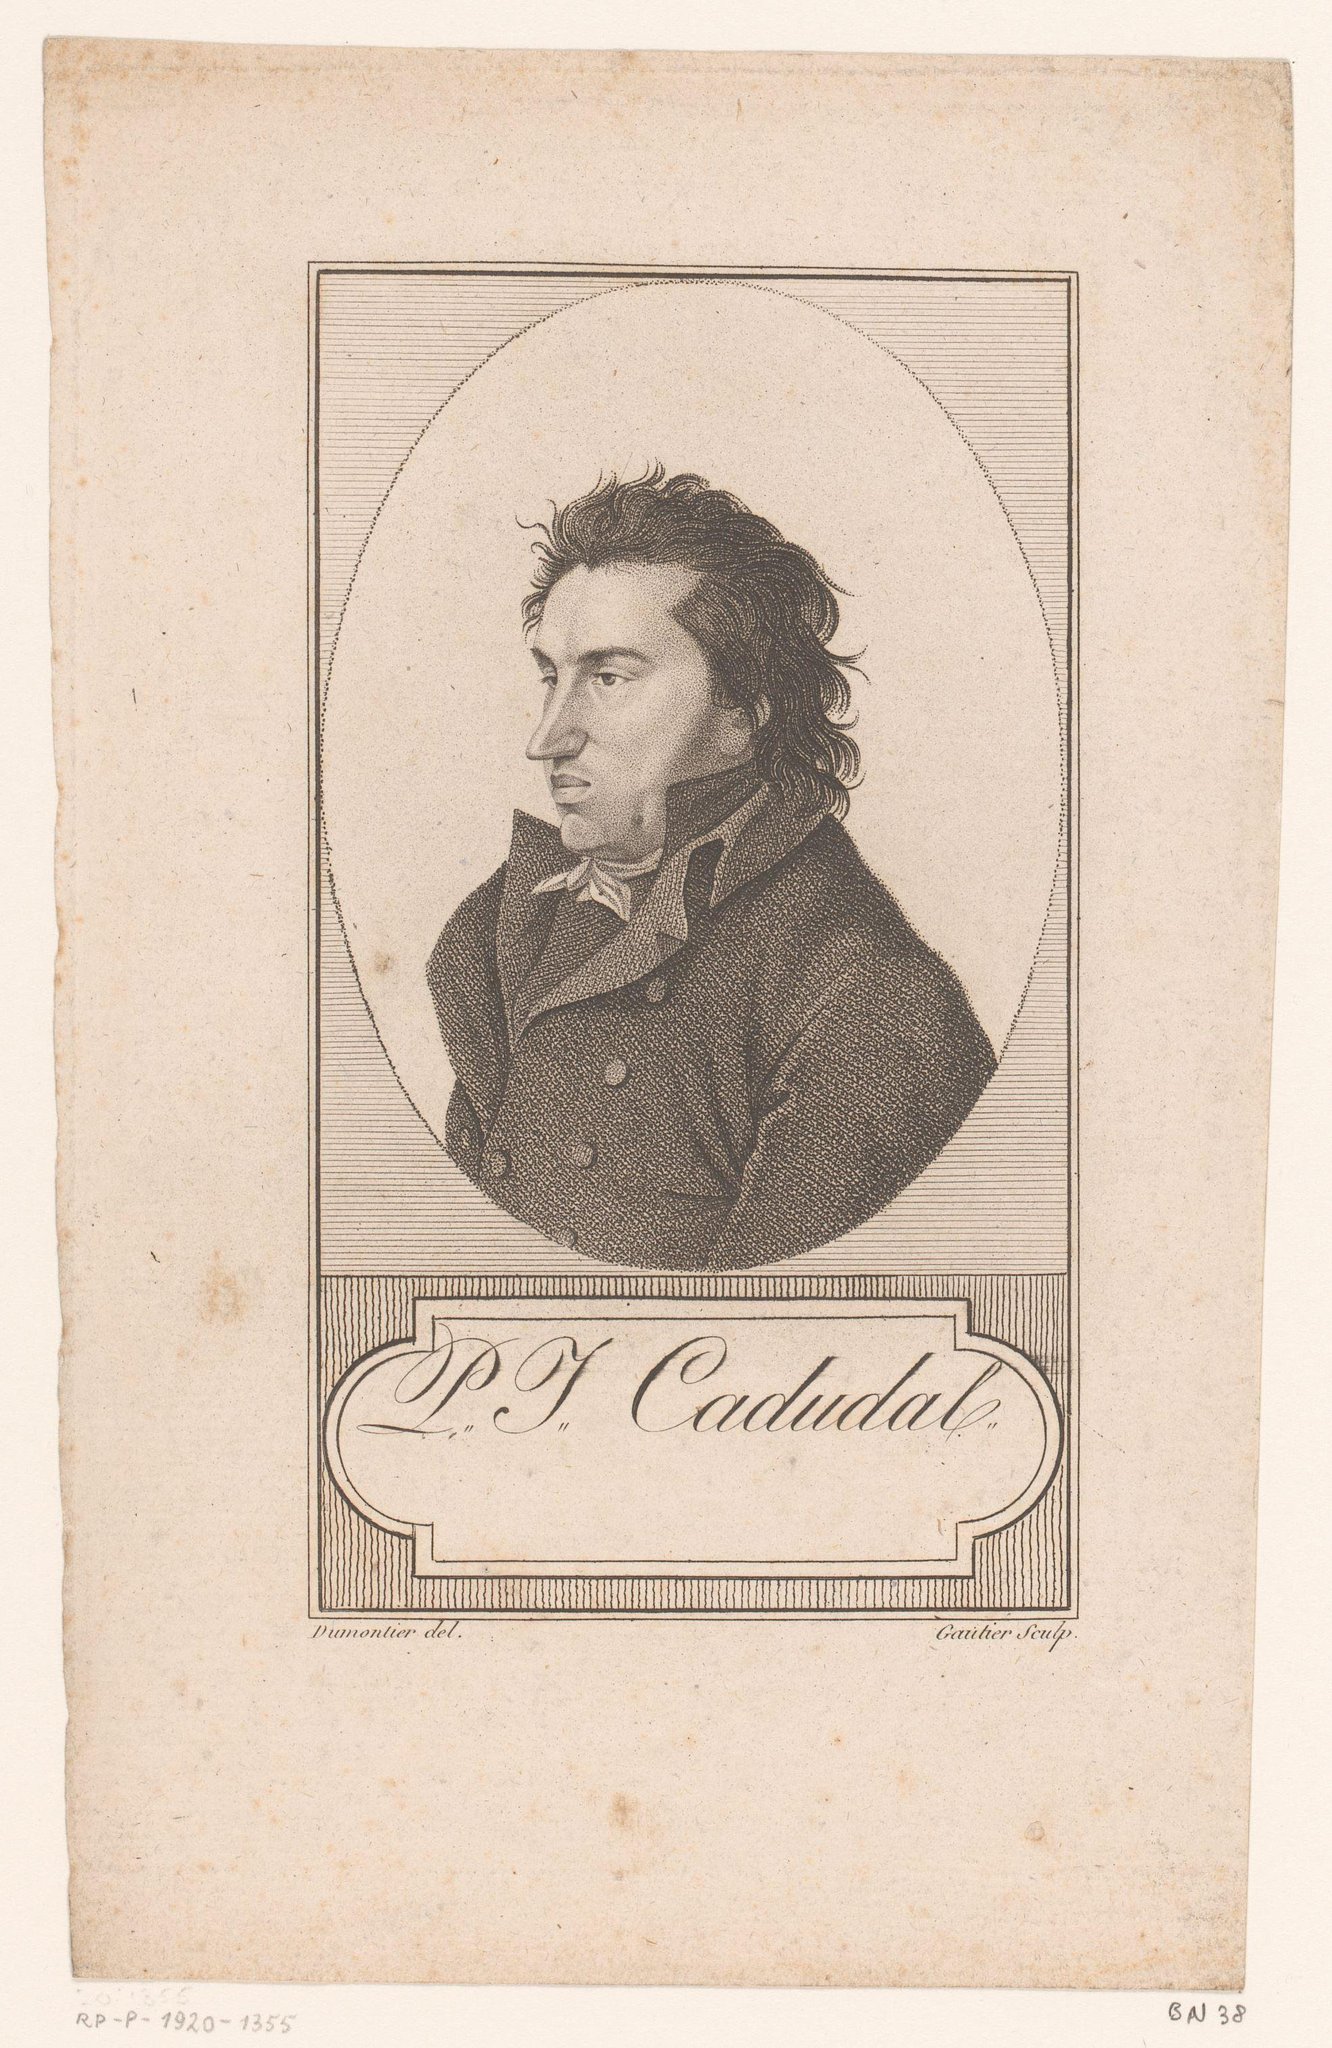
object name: book illustration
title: Portret van Pierre Jean Cadoudal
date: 1804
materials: paper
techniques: stippling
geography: france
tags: ornament ~ medallion, historical persons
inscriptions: collector's mark: Lugt 2228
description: Prent uit: s.n. Procès instruit par la cour de justice criminelle et speciale du département de la Seine, Séante a Paris contre Georges, Pichegru et autres, prévenus de conspiration contre la Peronne du Premier Consul. Parijs: Charles-Frobert Patris, 1804.